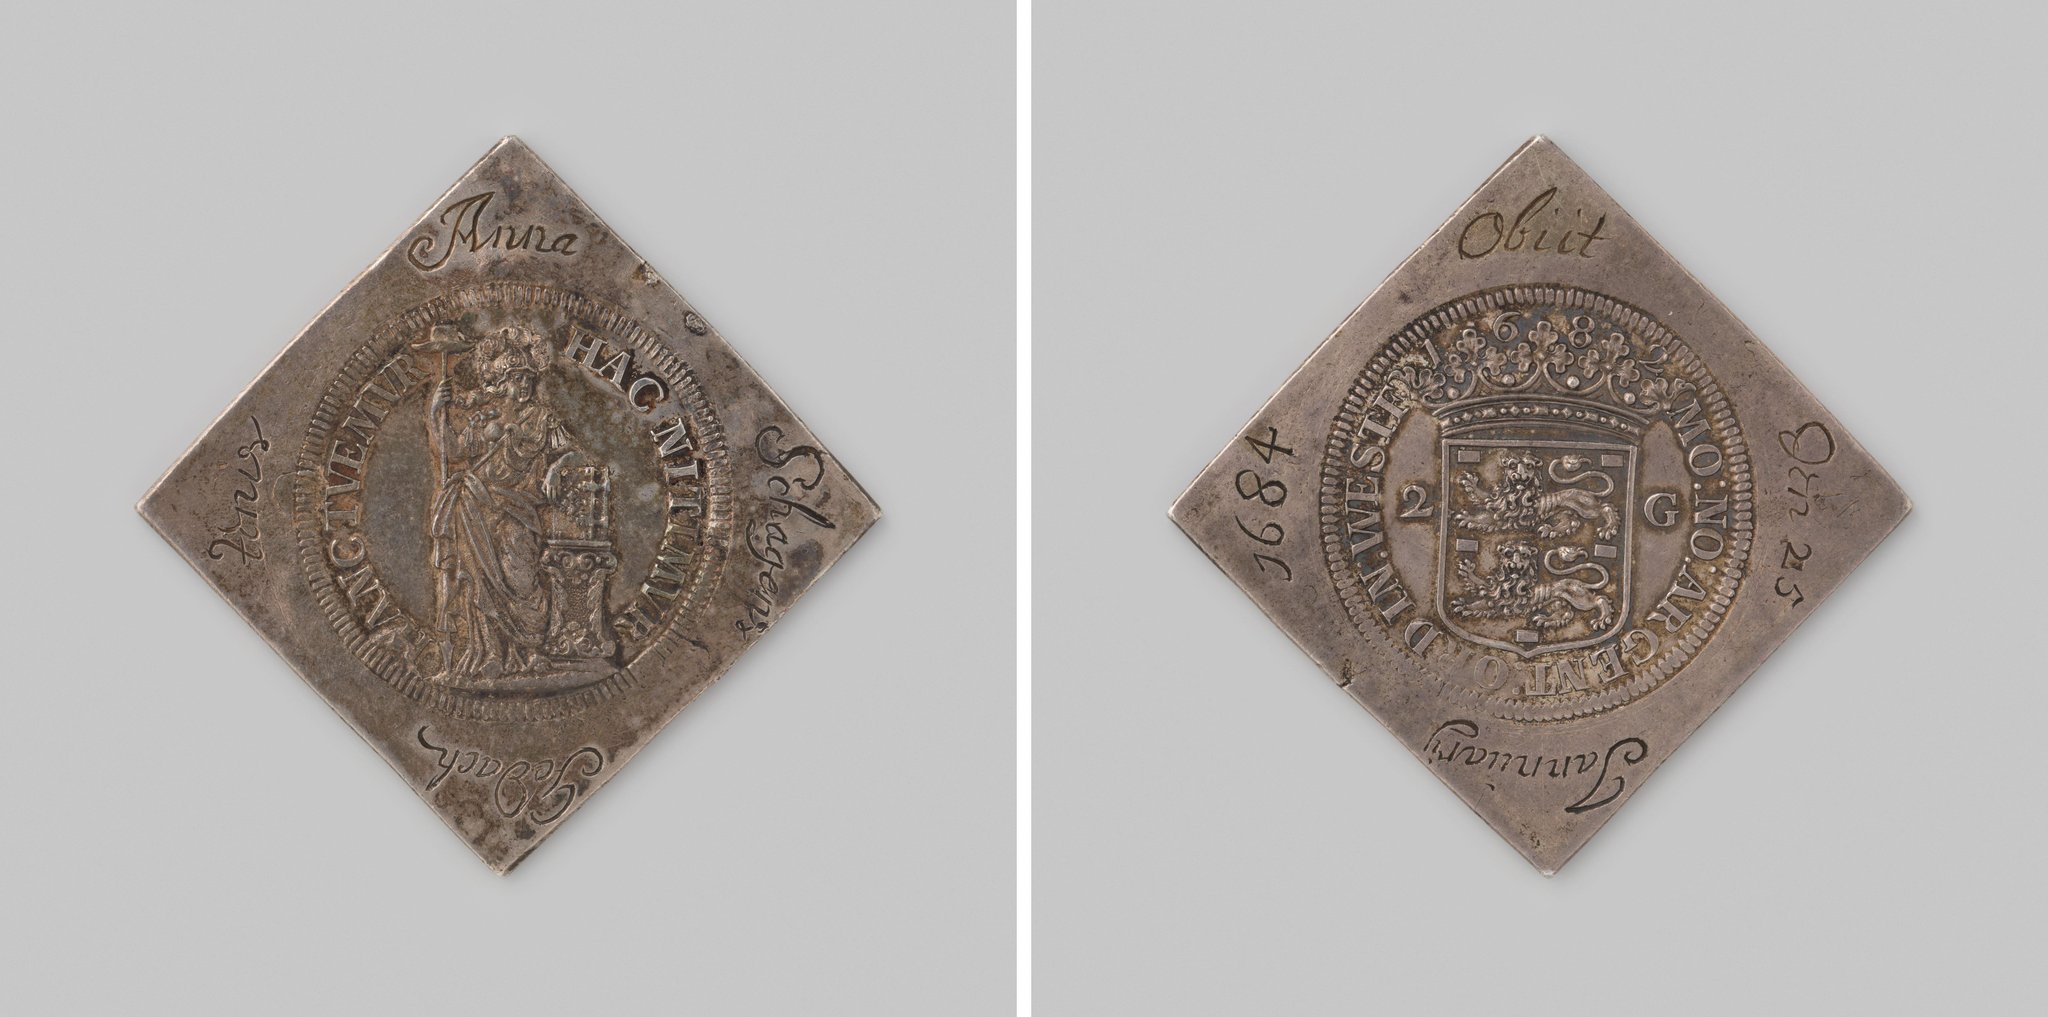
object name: history medal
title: Vierkante afslag van een twee-guldenstuk 1682 uit West-Friesland bewerkt tot penning op het overlijden van Anna Schagen 1684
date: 1684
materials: silver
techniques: engraving, striking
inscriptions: inscription: ‘Obiit - den 25 - Januarij - 1684’, inscription: ‘Anna - Schagens - Gedach - tenis’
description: Vierkante plaat zilver met afslagen van de stempels voor een Westfries 2-guldenstuk 1682, beiderzijds in de hoeken gegraveerde tekst.